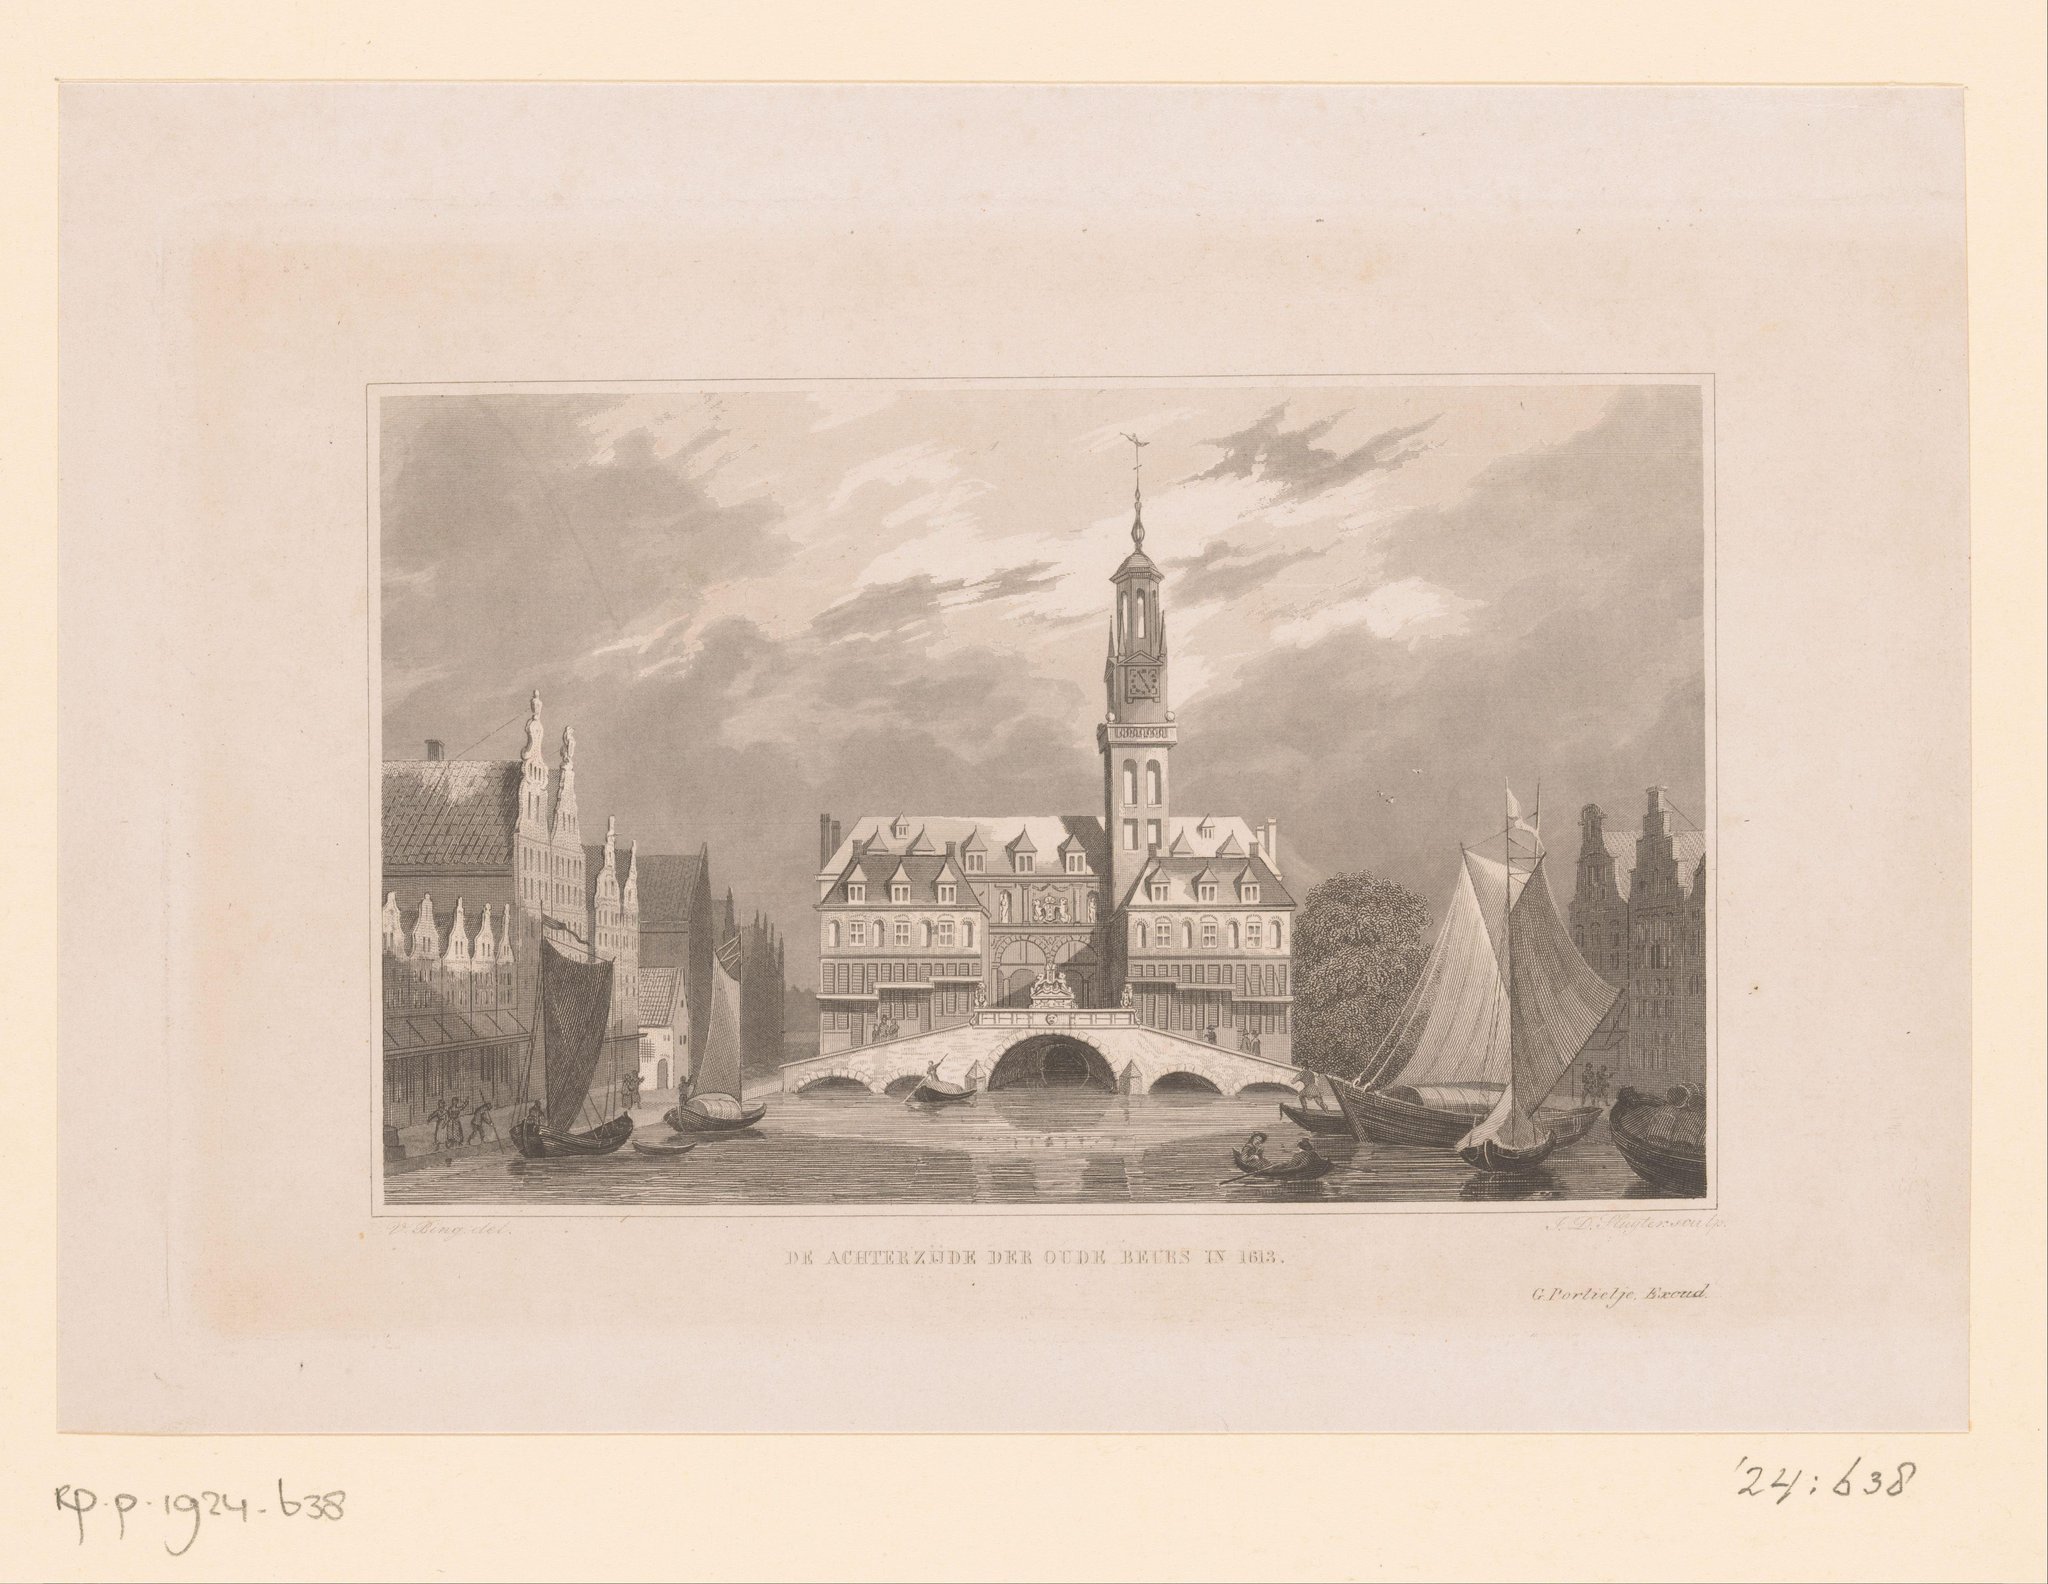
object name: print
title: De achterzijde der Oude Beurs in 1613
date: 1826-1886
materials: paper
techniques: engraving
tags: tower, clock tower ~ monumental adornment, stock exchange, stock-market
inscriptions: collector's mark: Lugt 2233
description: De Beurs van Hendrick de Keyser, vlak na voltooiing, en voor de verbouwing.